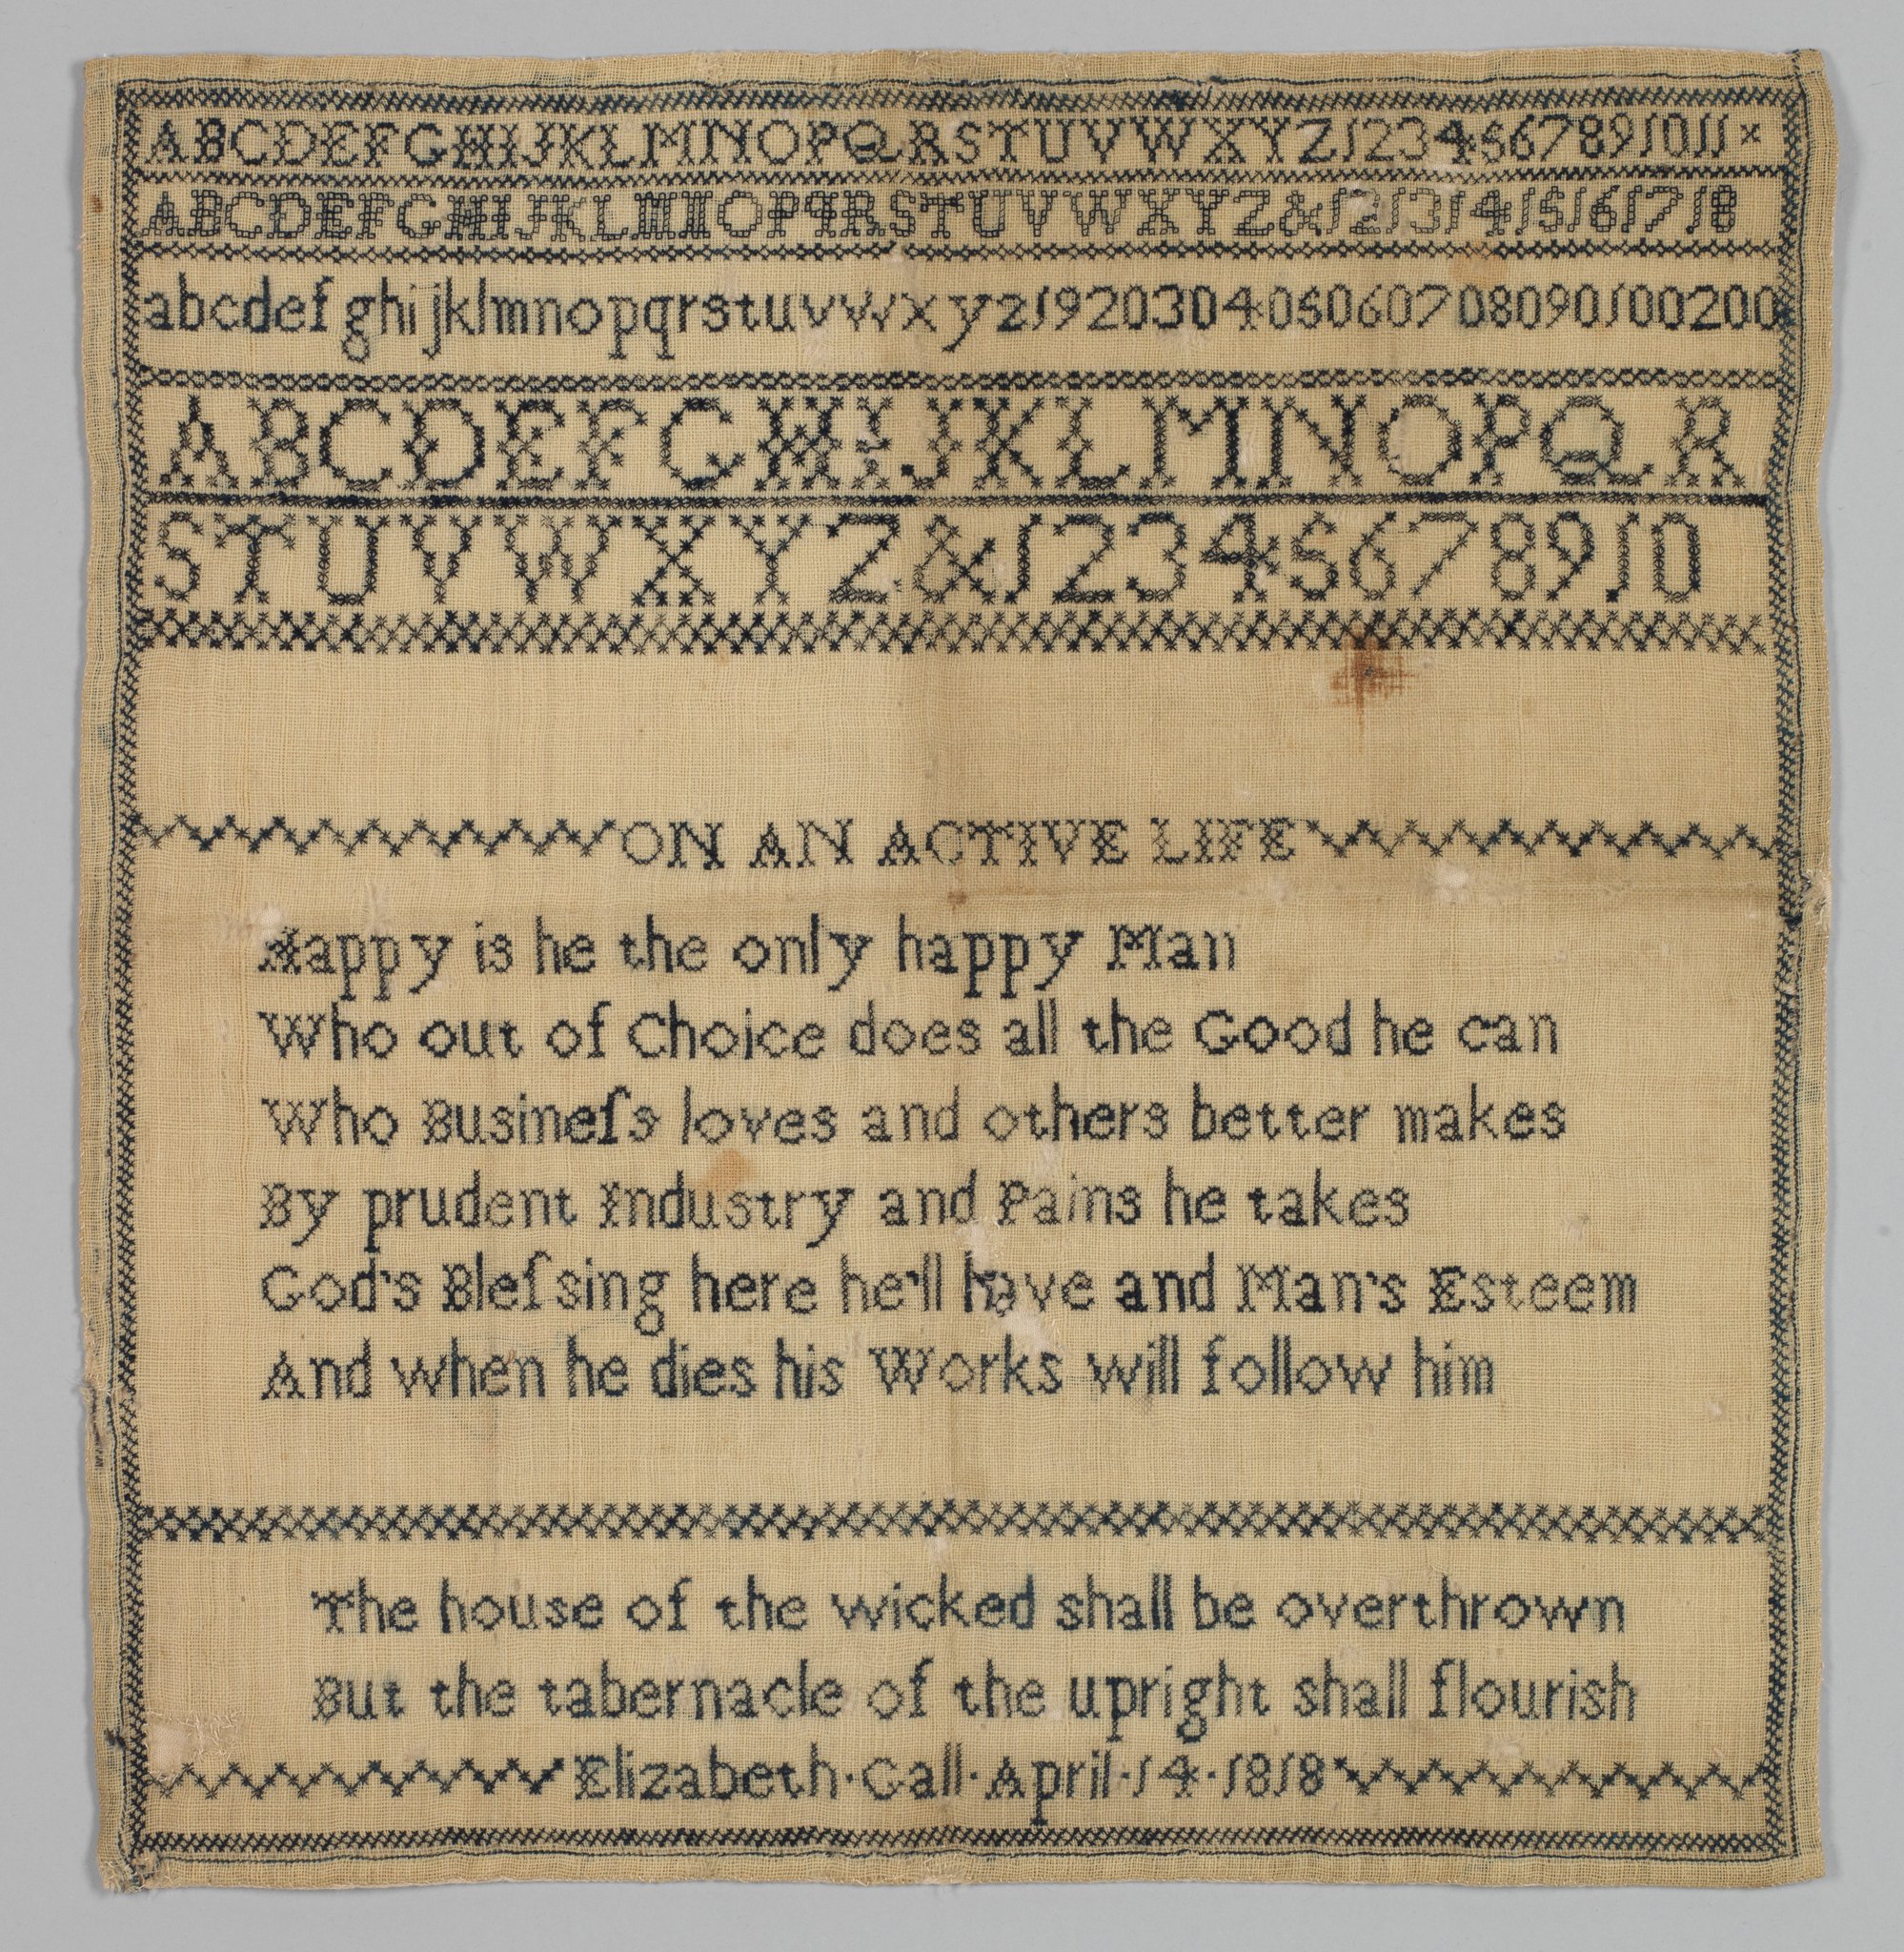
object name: sampler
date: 1818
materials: canvas, cotton, wool